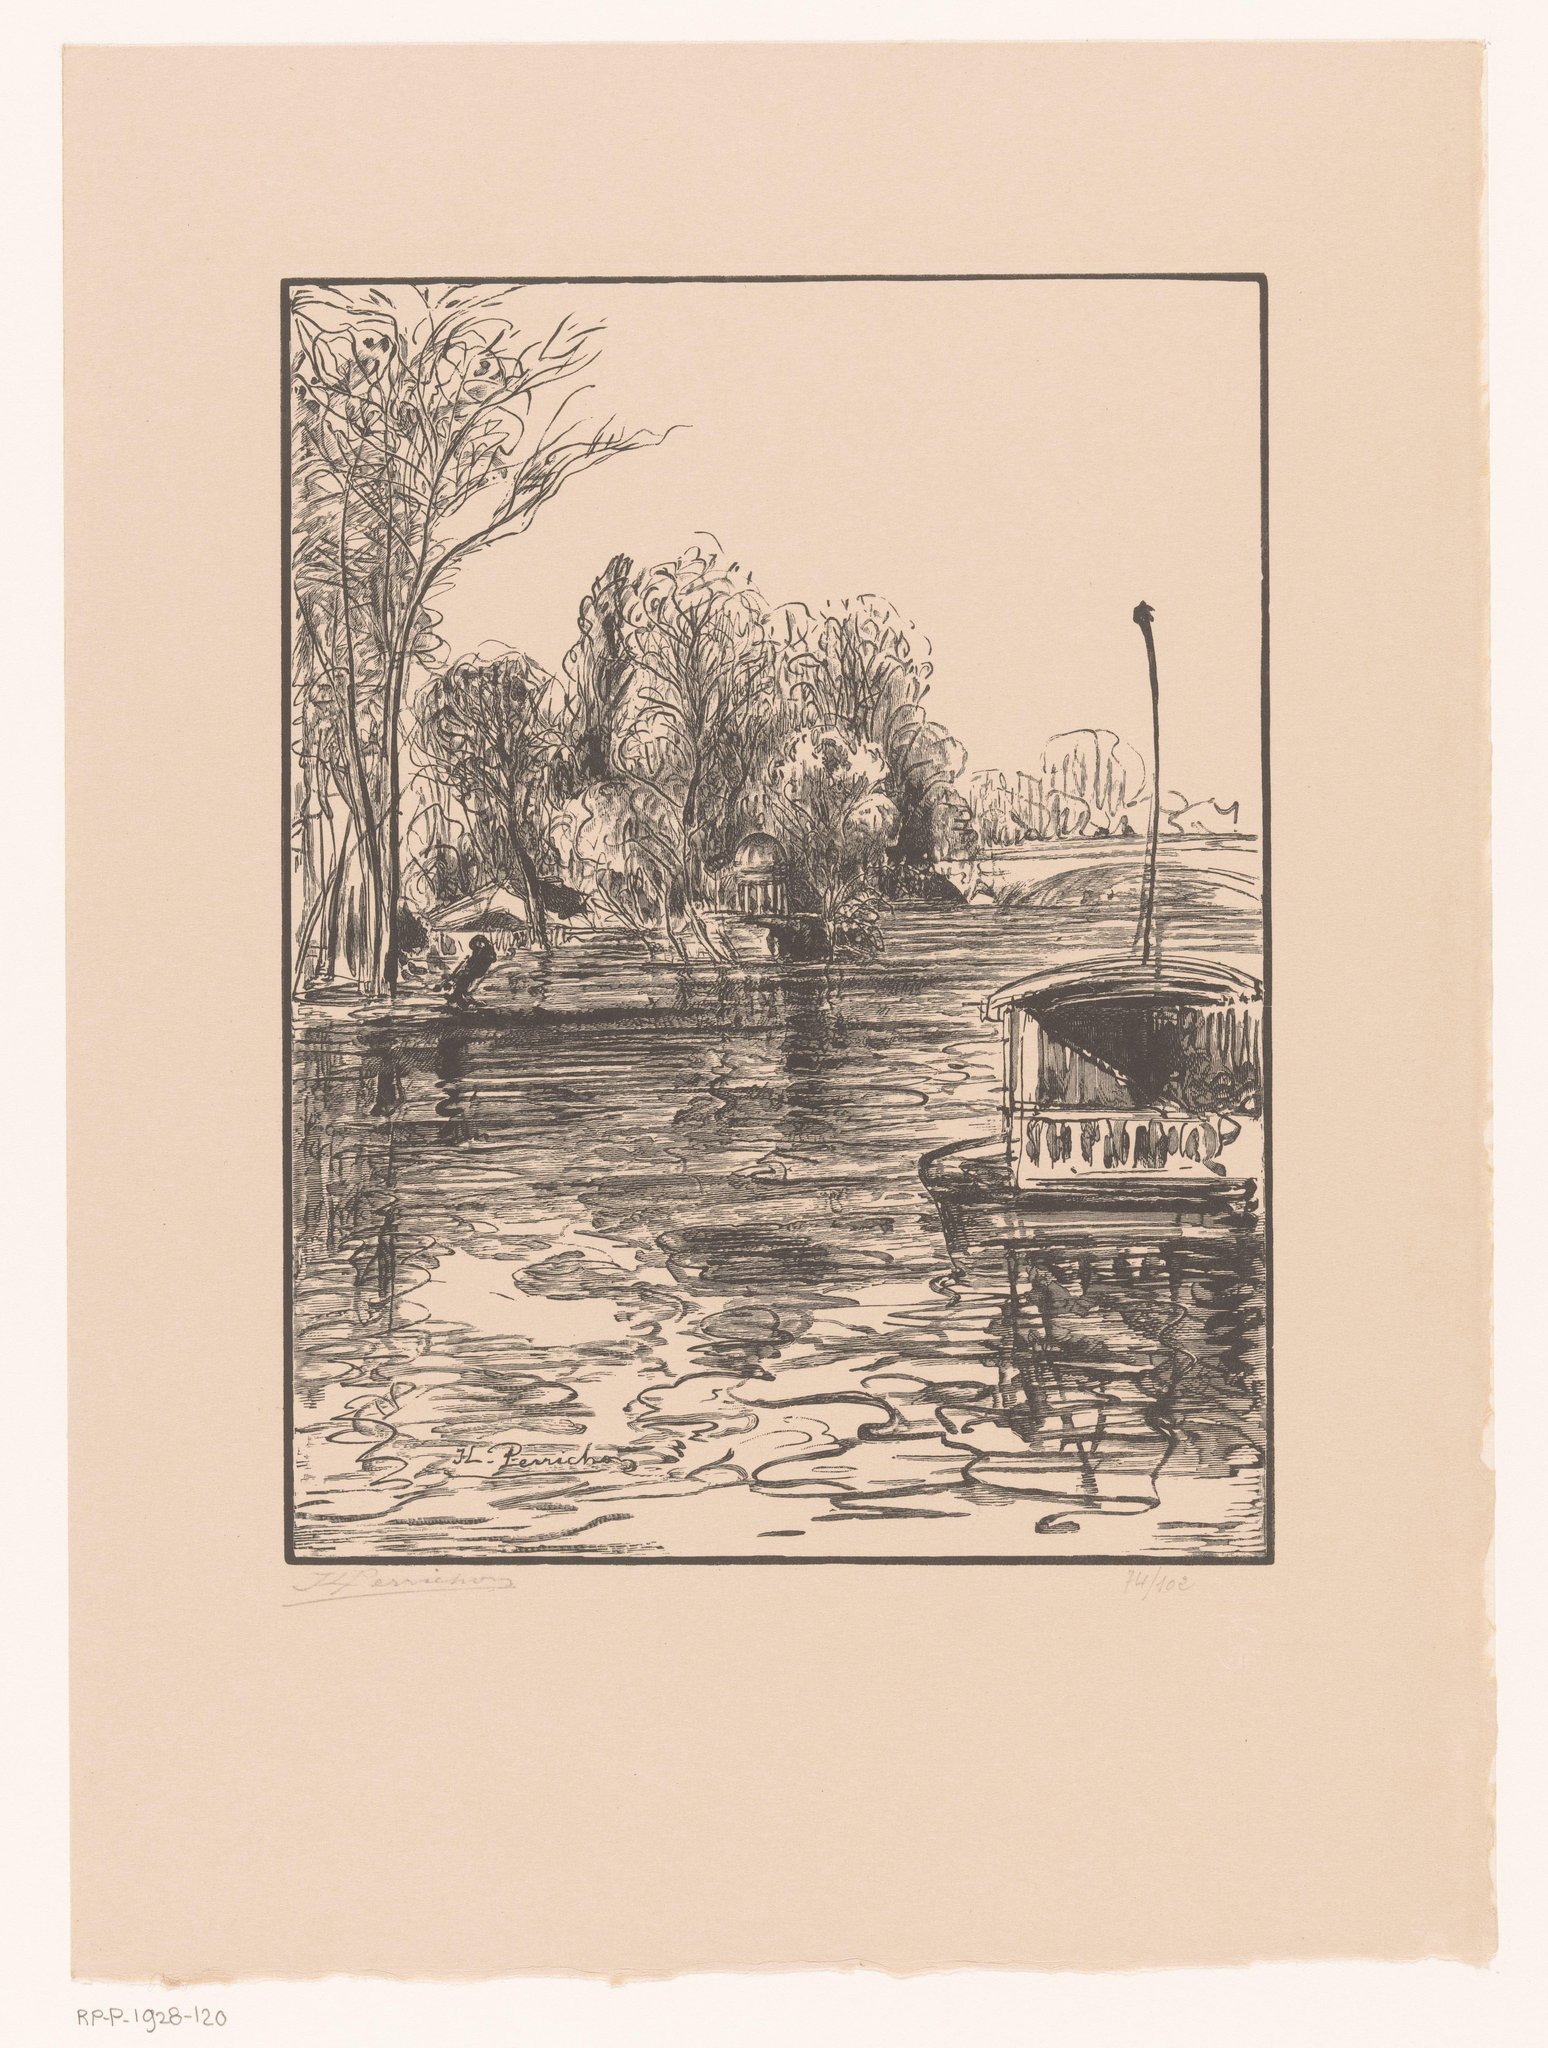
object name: print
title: Riviergezicht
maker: jules léon perrichon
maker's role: print maker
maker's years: 1866-1946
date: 1876-1928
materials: paper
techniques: engraving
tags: river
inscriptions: collector's mark: Lugt 2228, check stamp: Lugt 1195a